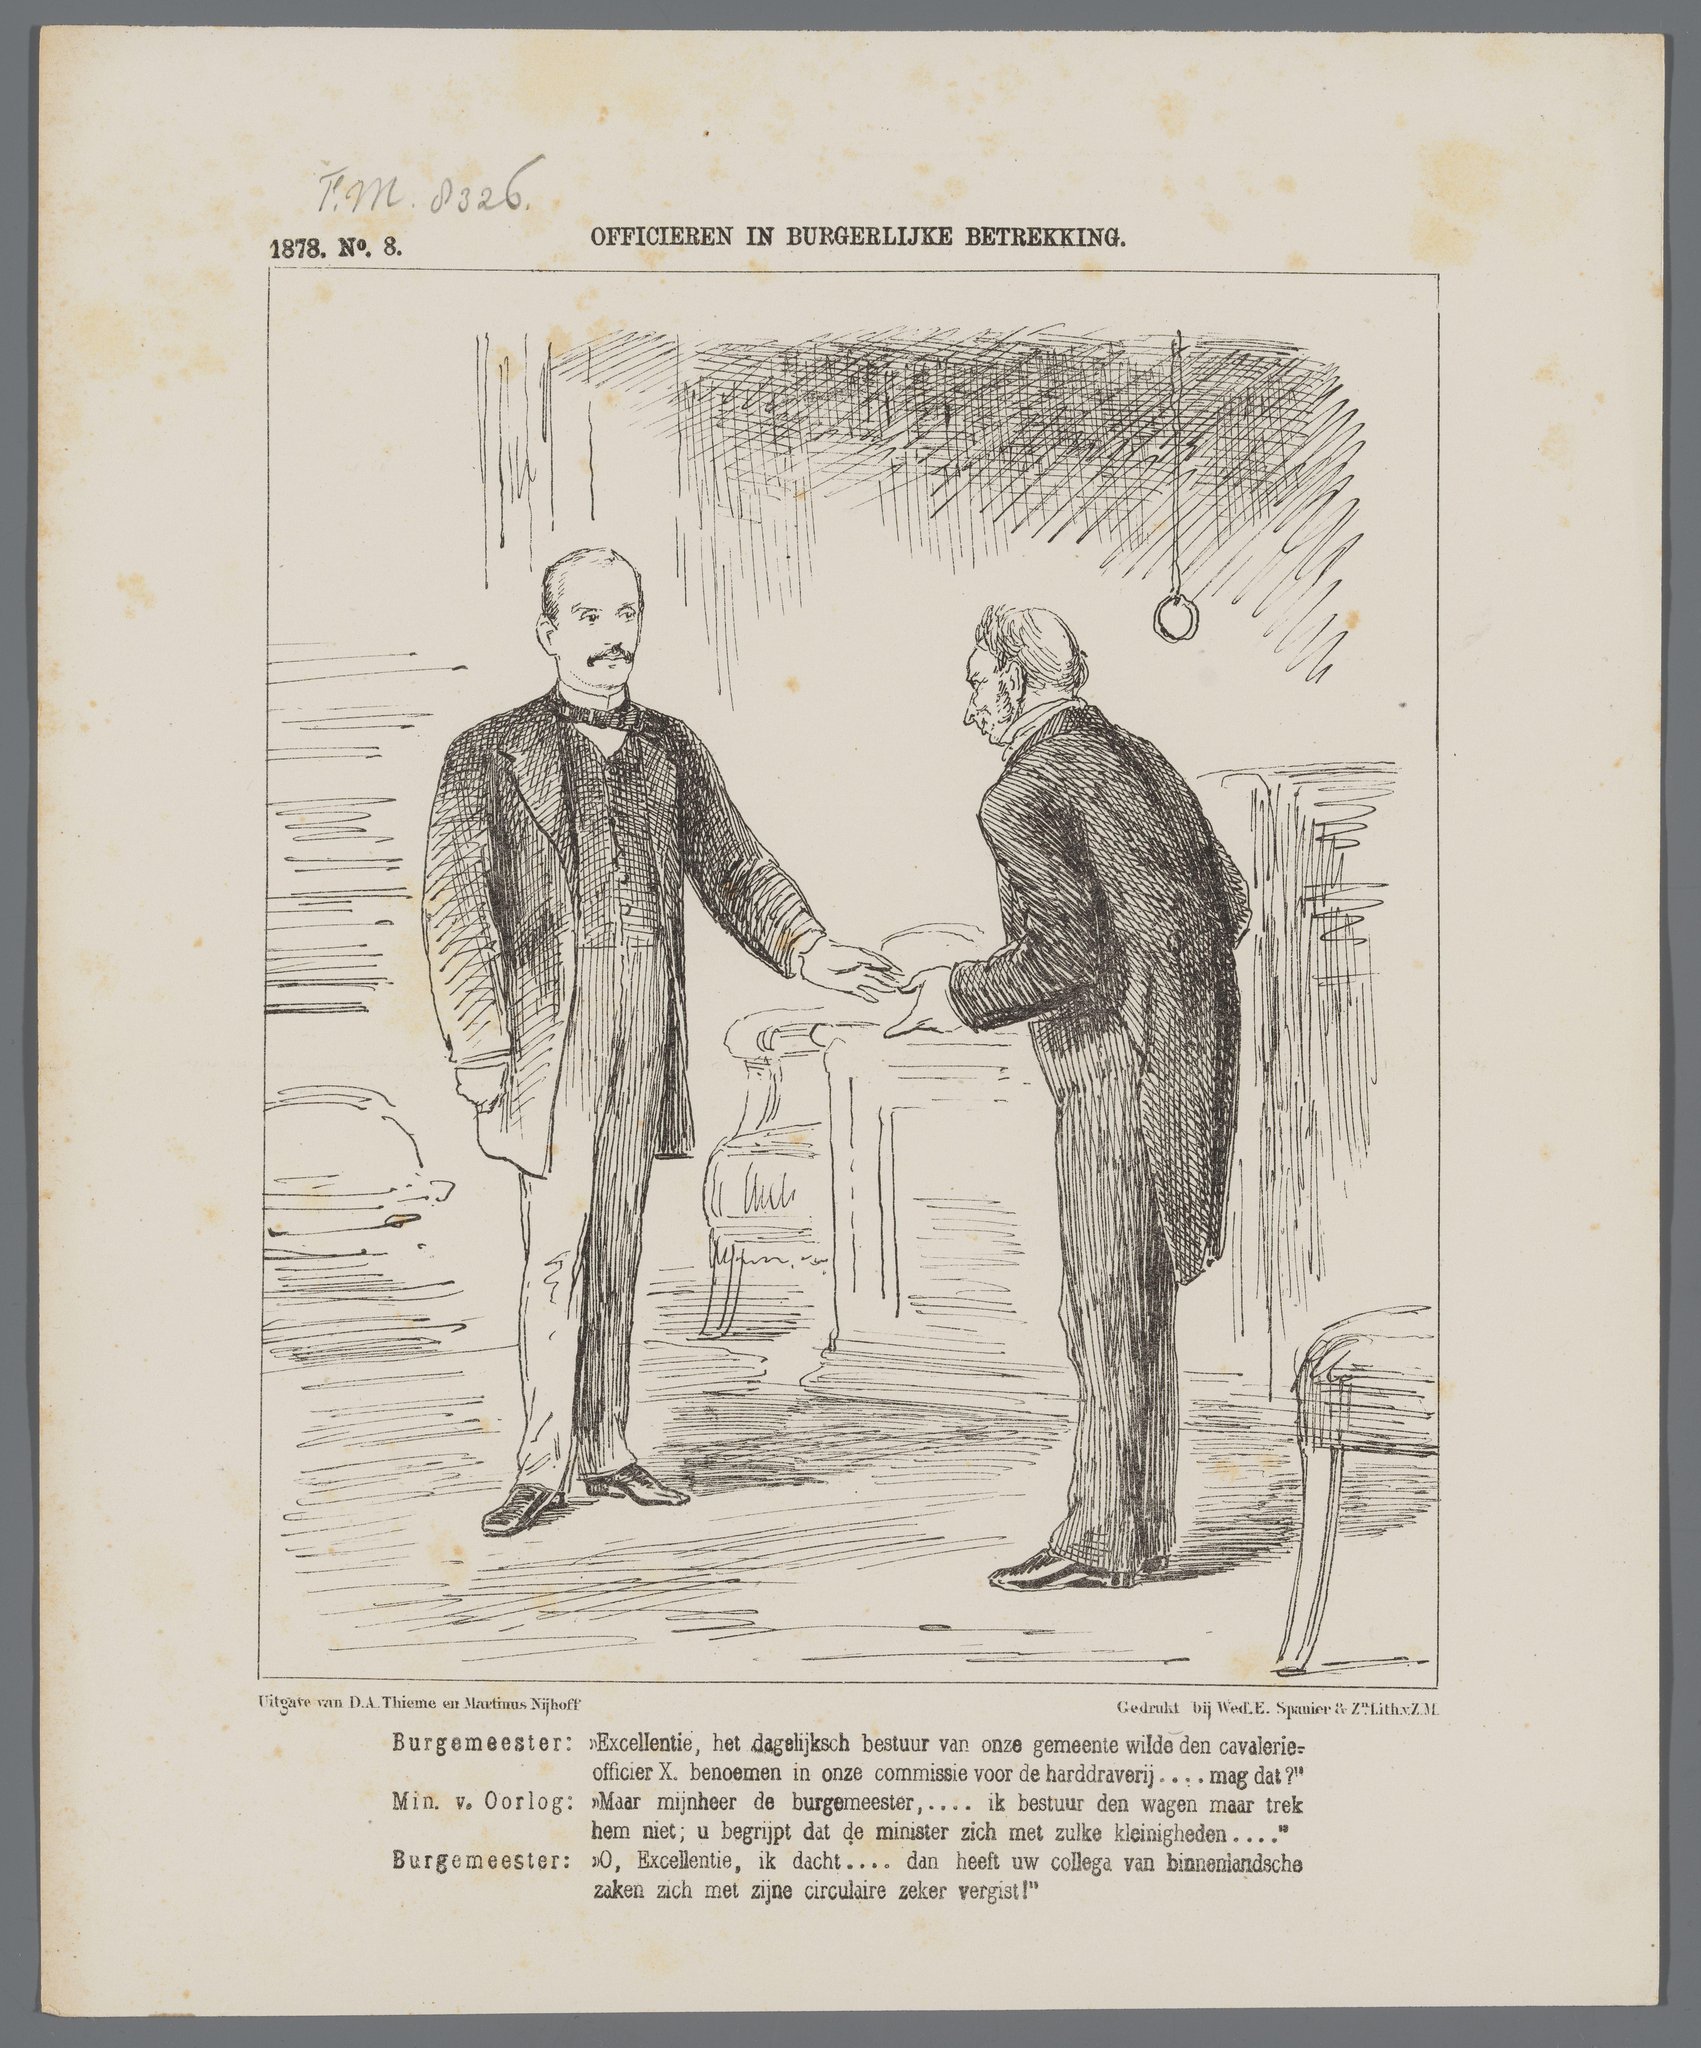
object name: cartoon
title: Officieren in burgerlijke betrekking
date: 1878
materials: paper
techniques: lithograph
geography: netherlands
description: Spotprent. Plaat verschenen bij het weekblad De Nederlandsche Spectator, nr. 8, 1878.